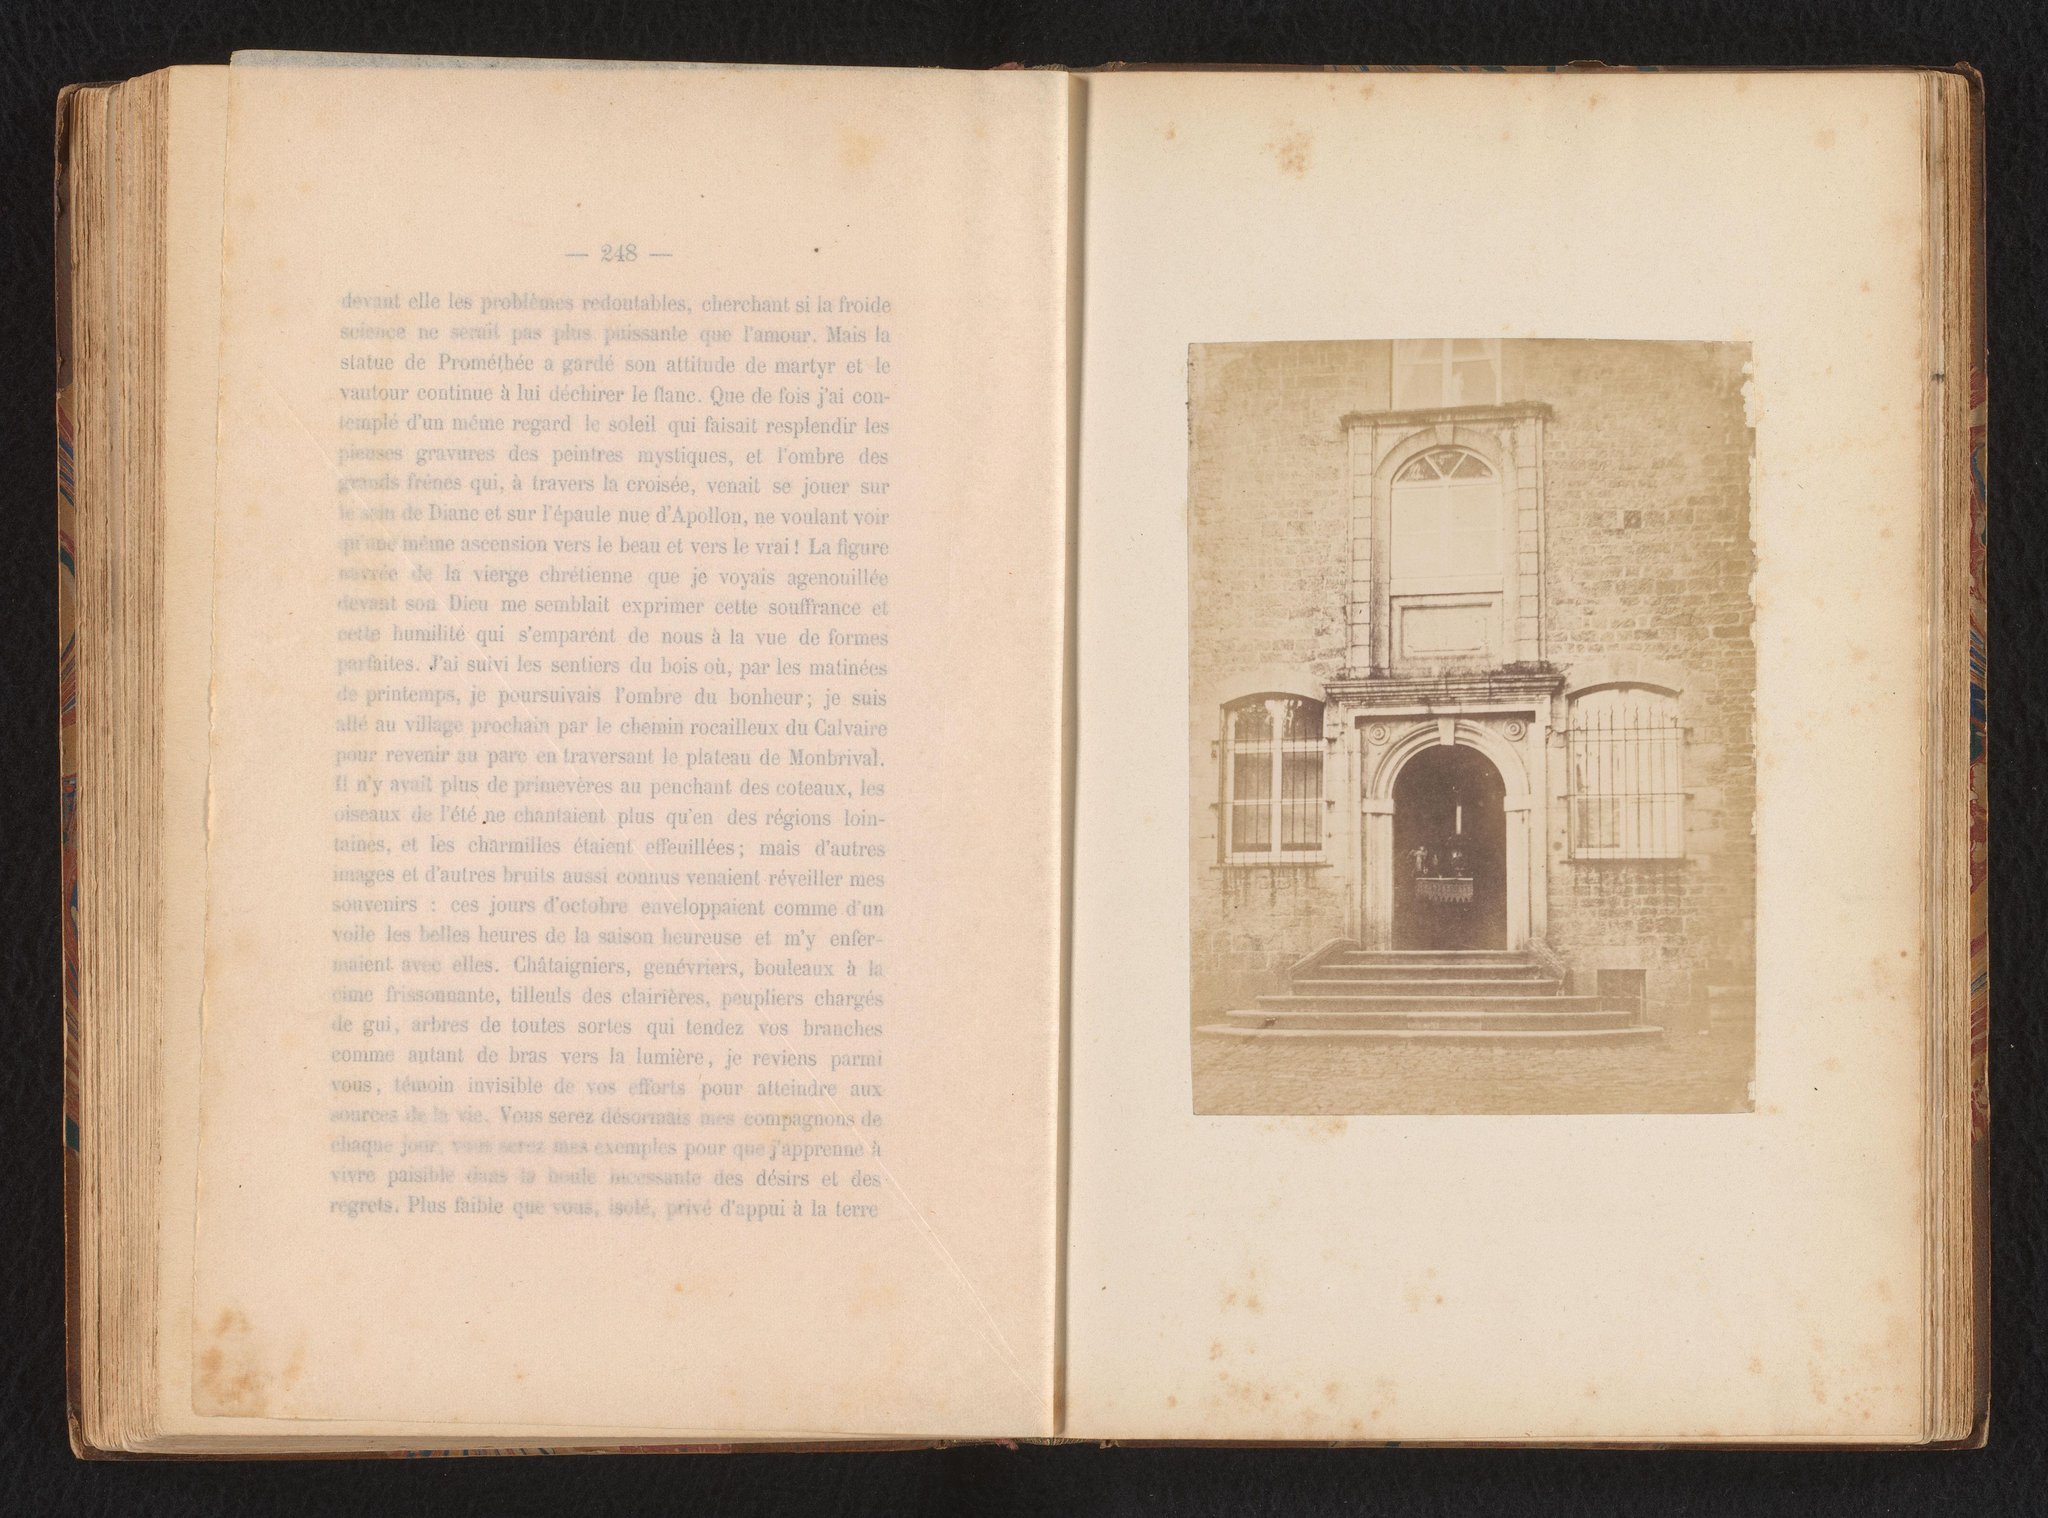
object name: page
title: Ingang van kasteel Pirmez in Gerpinnes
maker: Anonymous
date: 1864-1869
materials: paper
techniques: albumen print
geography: gerpinnes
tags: gate, entrance